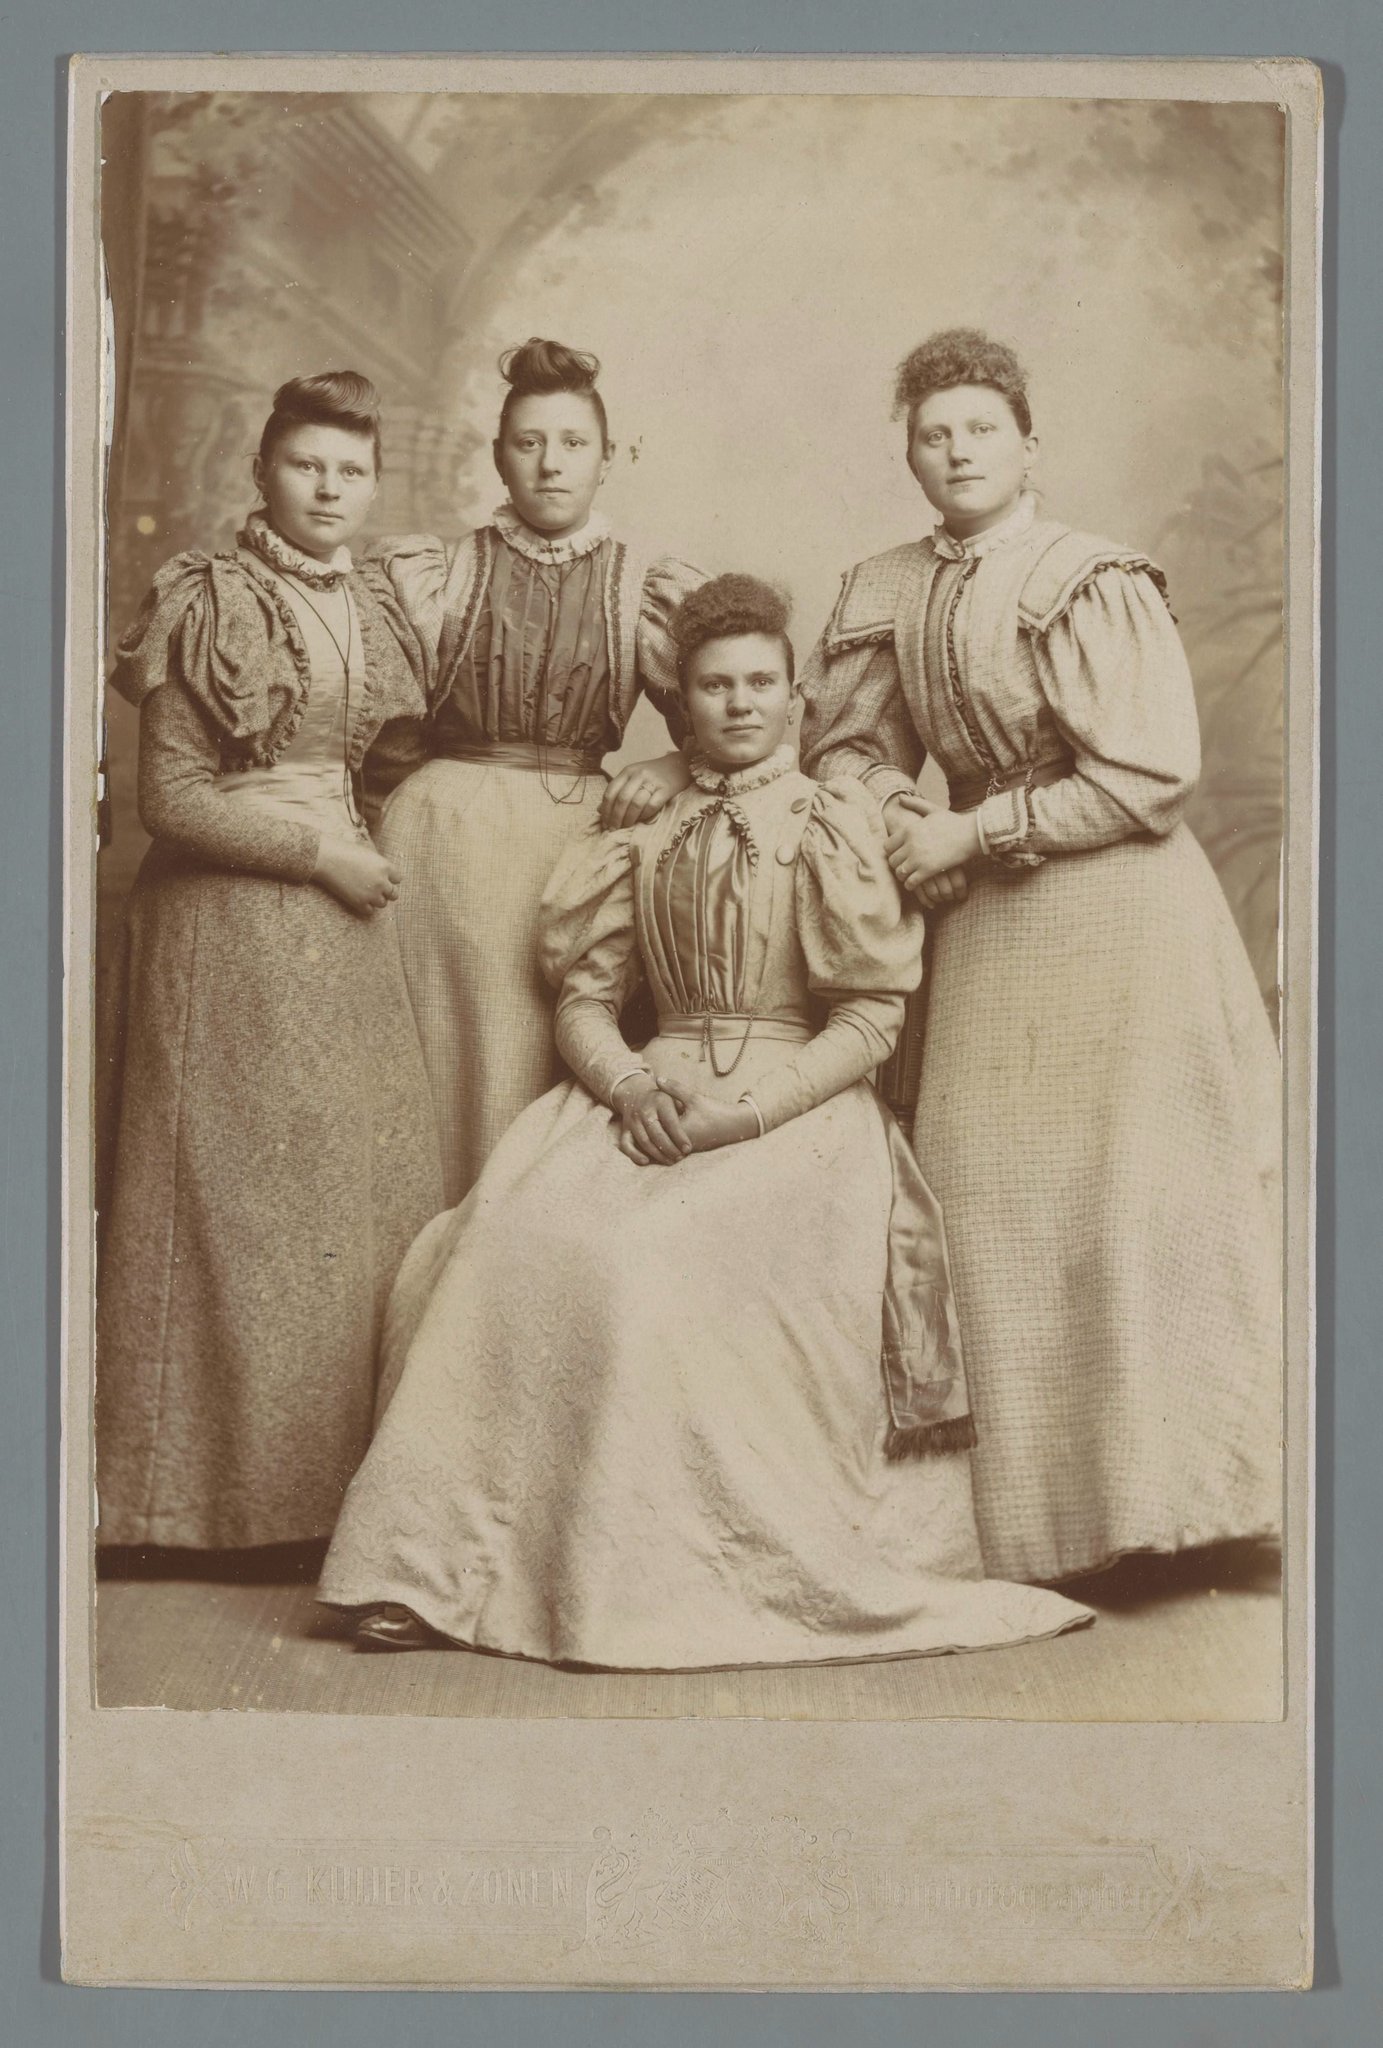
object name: cabinet photograph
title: Portret van vier onbekende vrouwen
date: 1885-1906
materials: cardboard, photographic support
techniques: collodion silver print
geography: amsterdam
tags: adult woman, studio requisites ~ photographer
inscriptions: name: ‘W.G. Kuijer & Zonen Hofphotographen Westermarkt 19, Amsterdam’